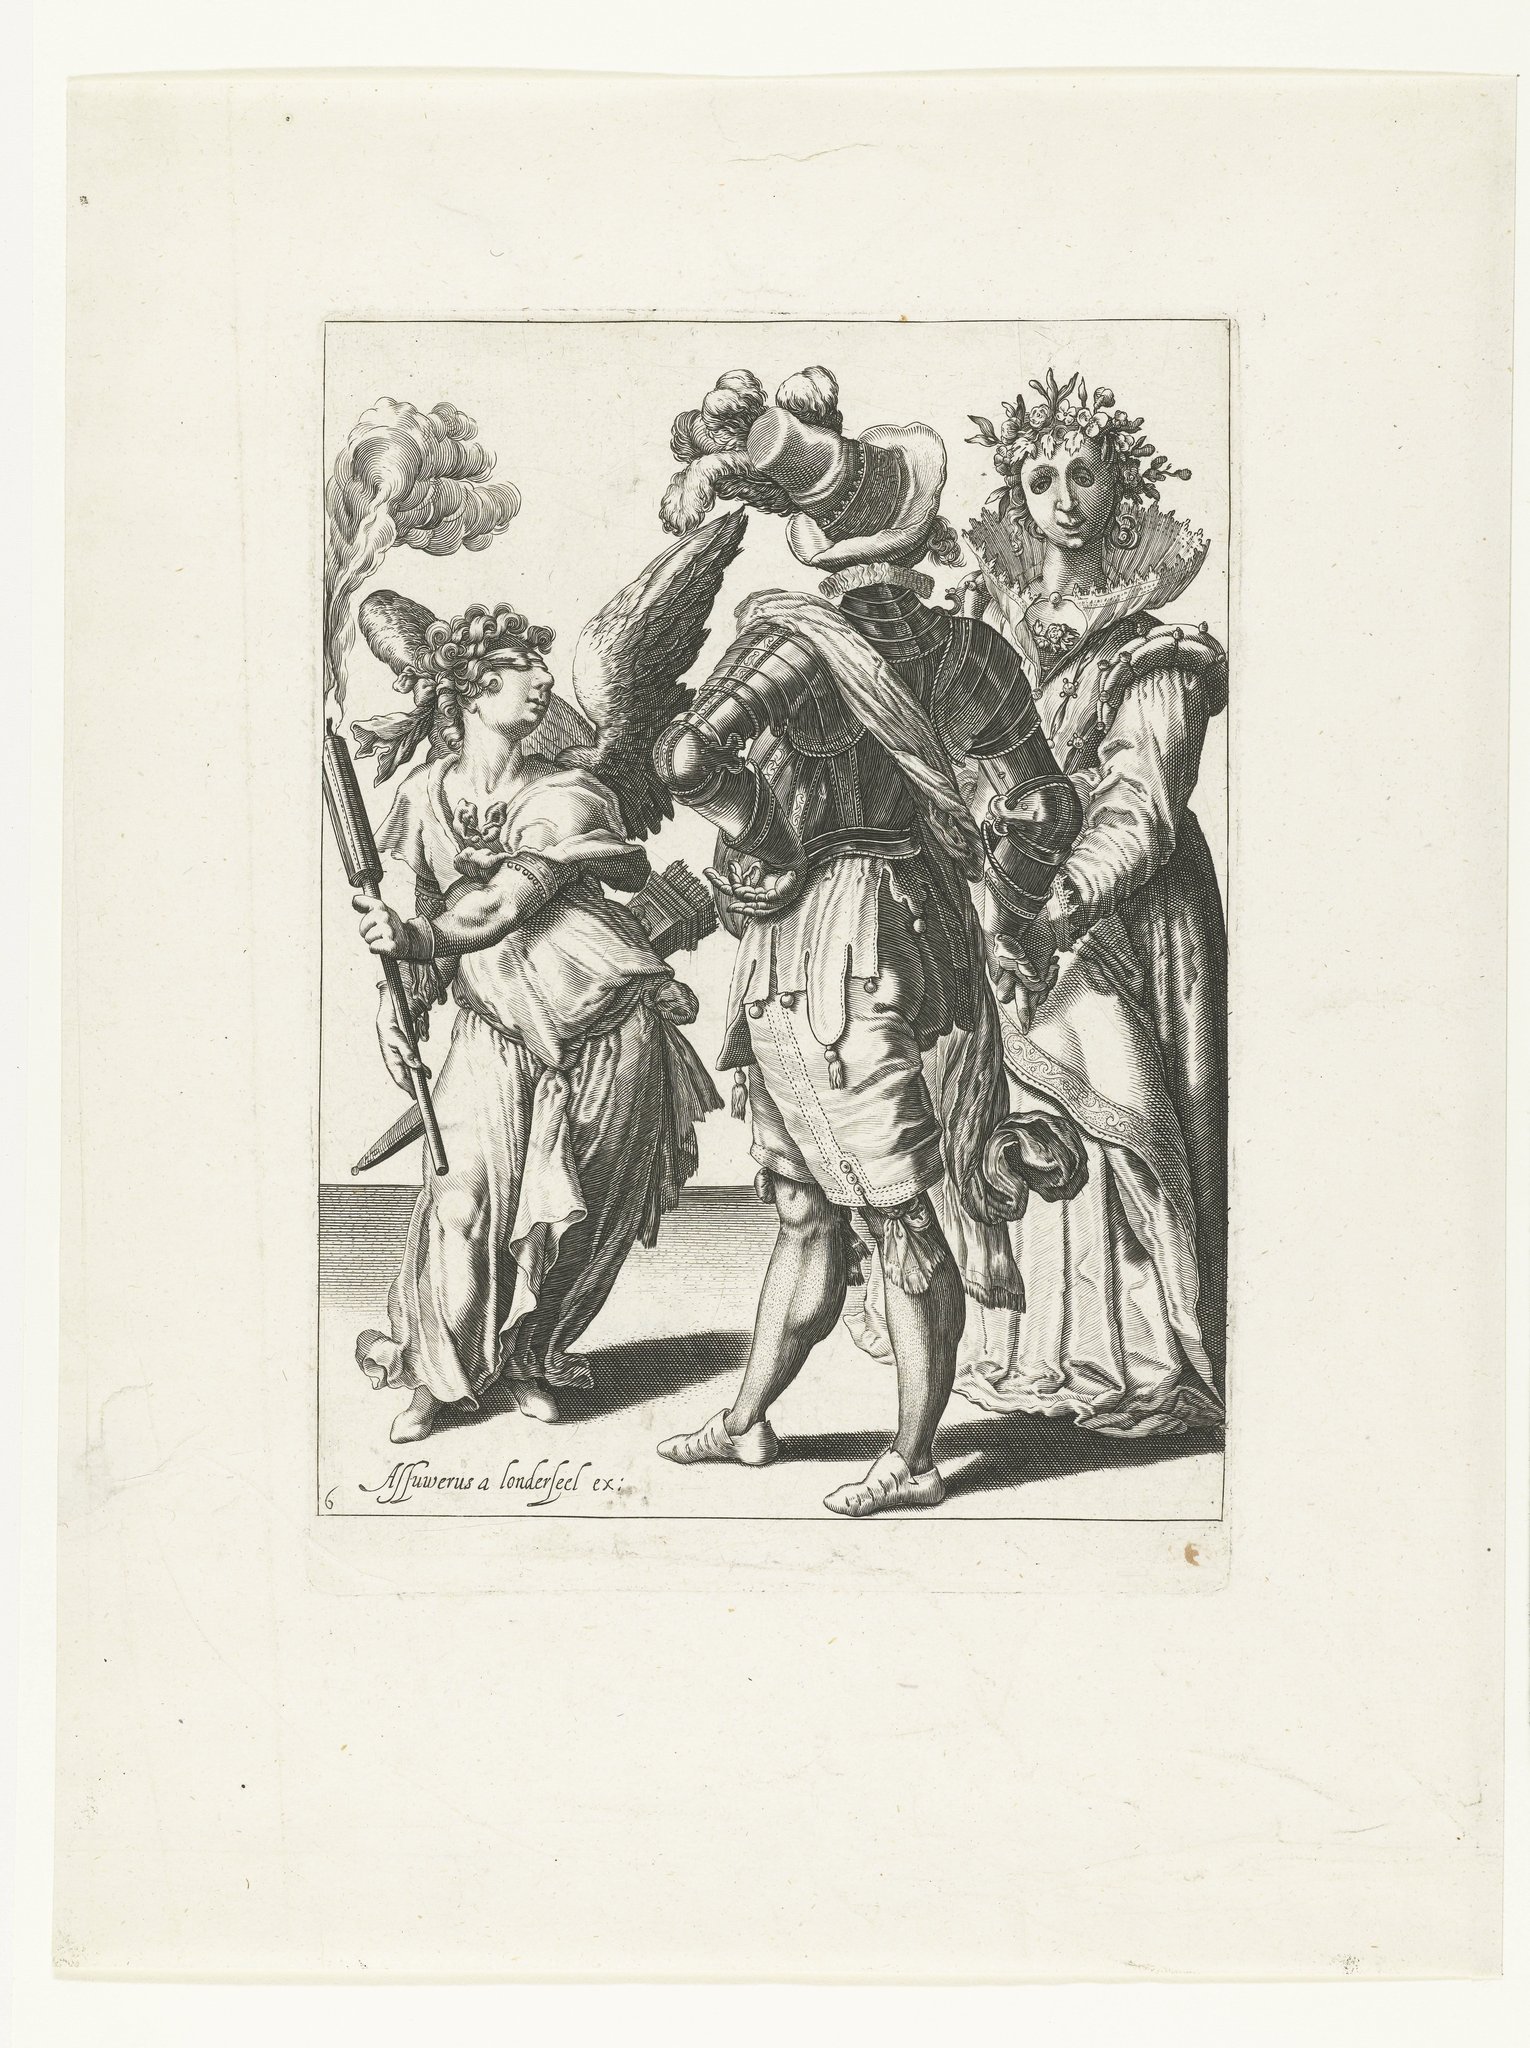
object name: print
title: Een geblinddoekte Cupido met een fakkel voor een stel in feestelijke kledij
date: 1596-1635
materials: paper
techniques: engraving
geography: netherlands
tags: torch, masquerade, masked ball, cupids: 'amores', 'amoretti', 'putti'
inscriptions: collector's mark: Lugt 2228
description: Een geblinddoekte Cupido houdt een brandende fakkel voor een man en een vrouw in feestelijke kledij die hand in hand naast hem staan. Deze prent is onderdeel van een serie van negen genummerde prenten, waarop twee of drie gemaskerde en/of verklede figuren ten voeten uit zijn weergegeven.